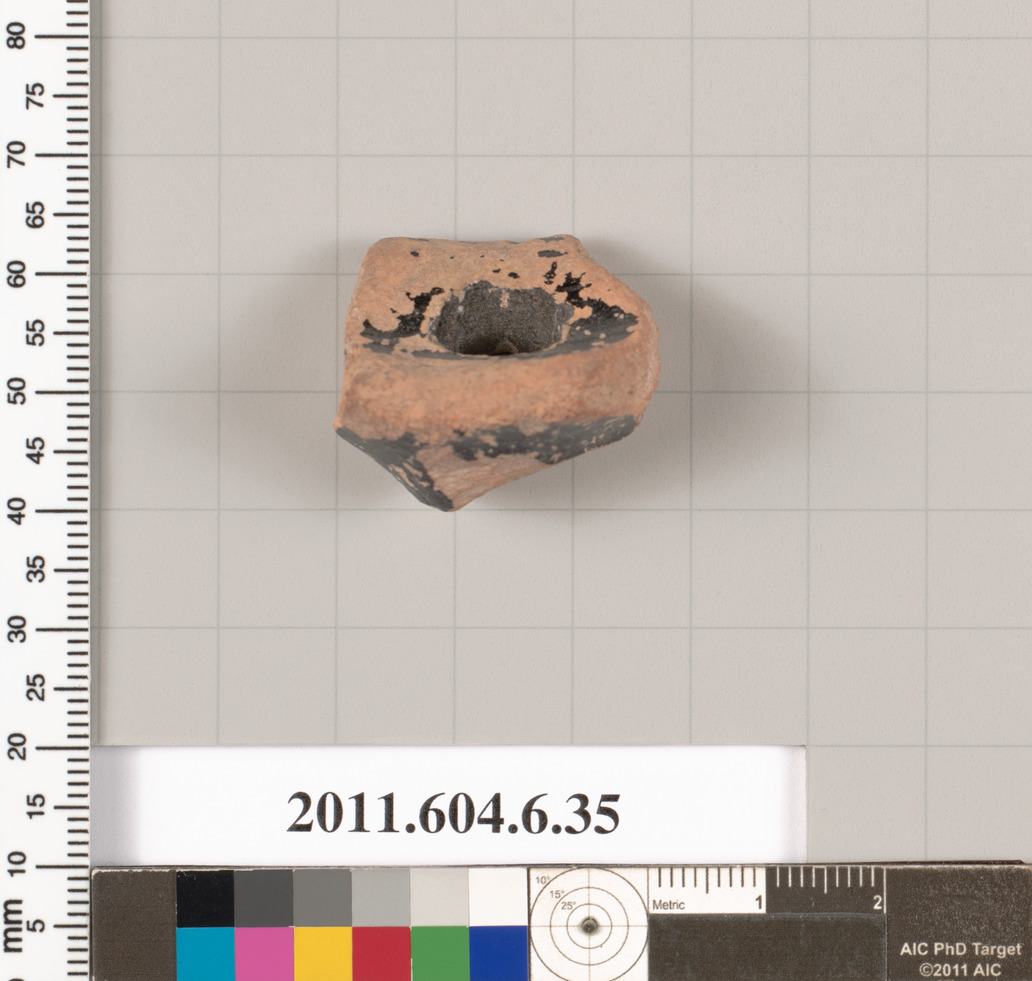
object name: undetermined shape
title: Terracotta fragment of an undetermined shape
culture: greek, attic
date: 600-401 BCE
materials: terracotta